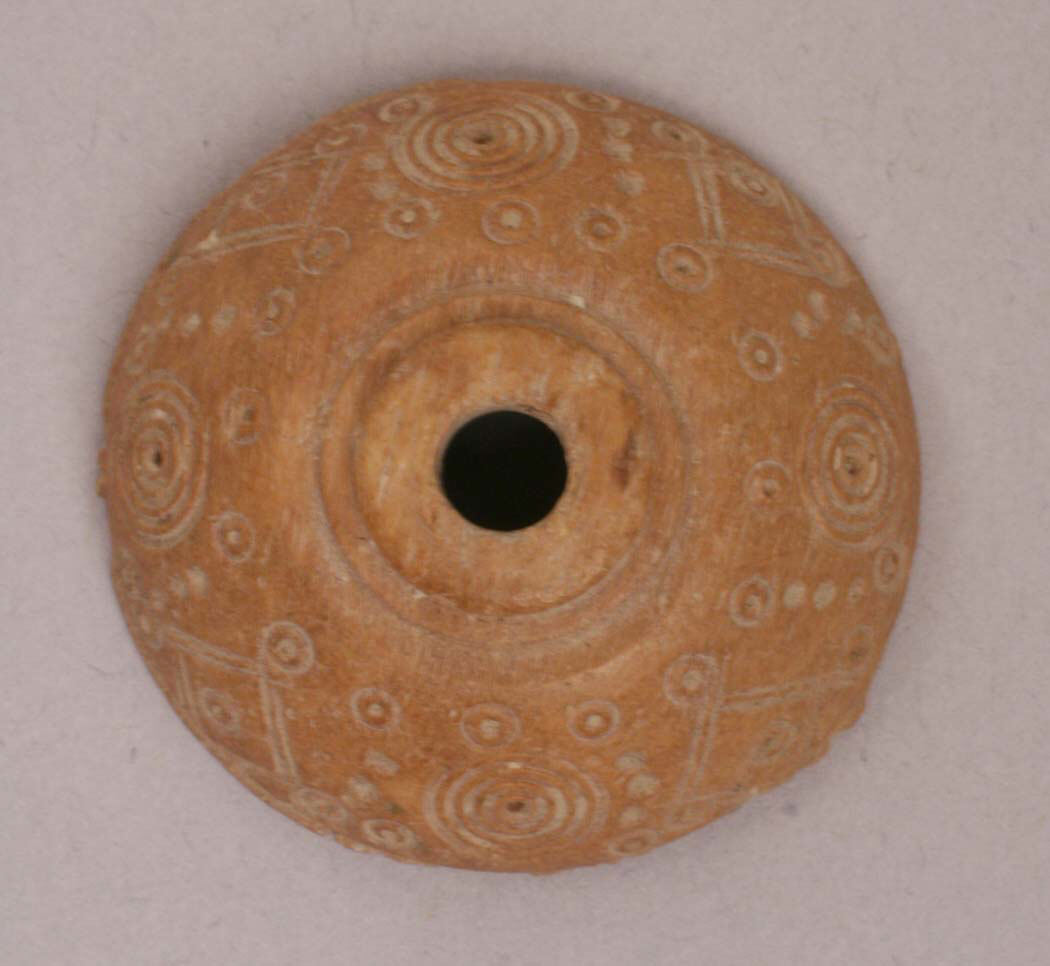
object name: button or spindle whorl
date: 801-1000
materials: bone, paint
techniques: incising, inlay, tinting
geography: iran